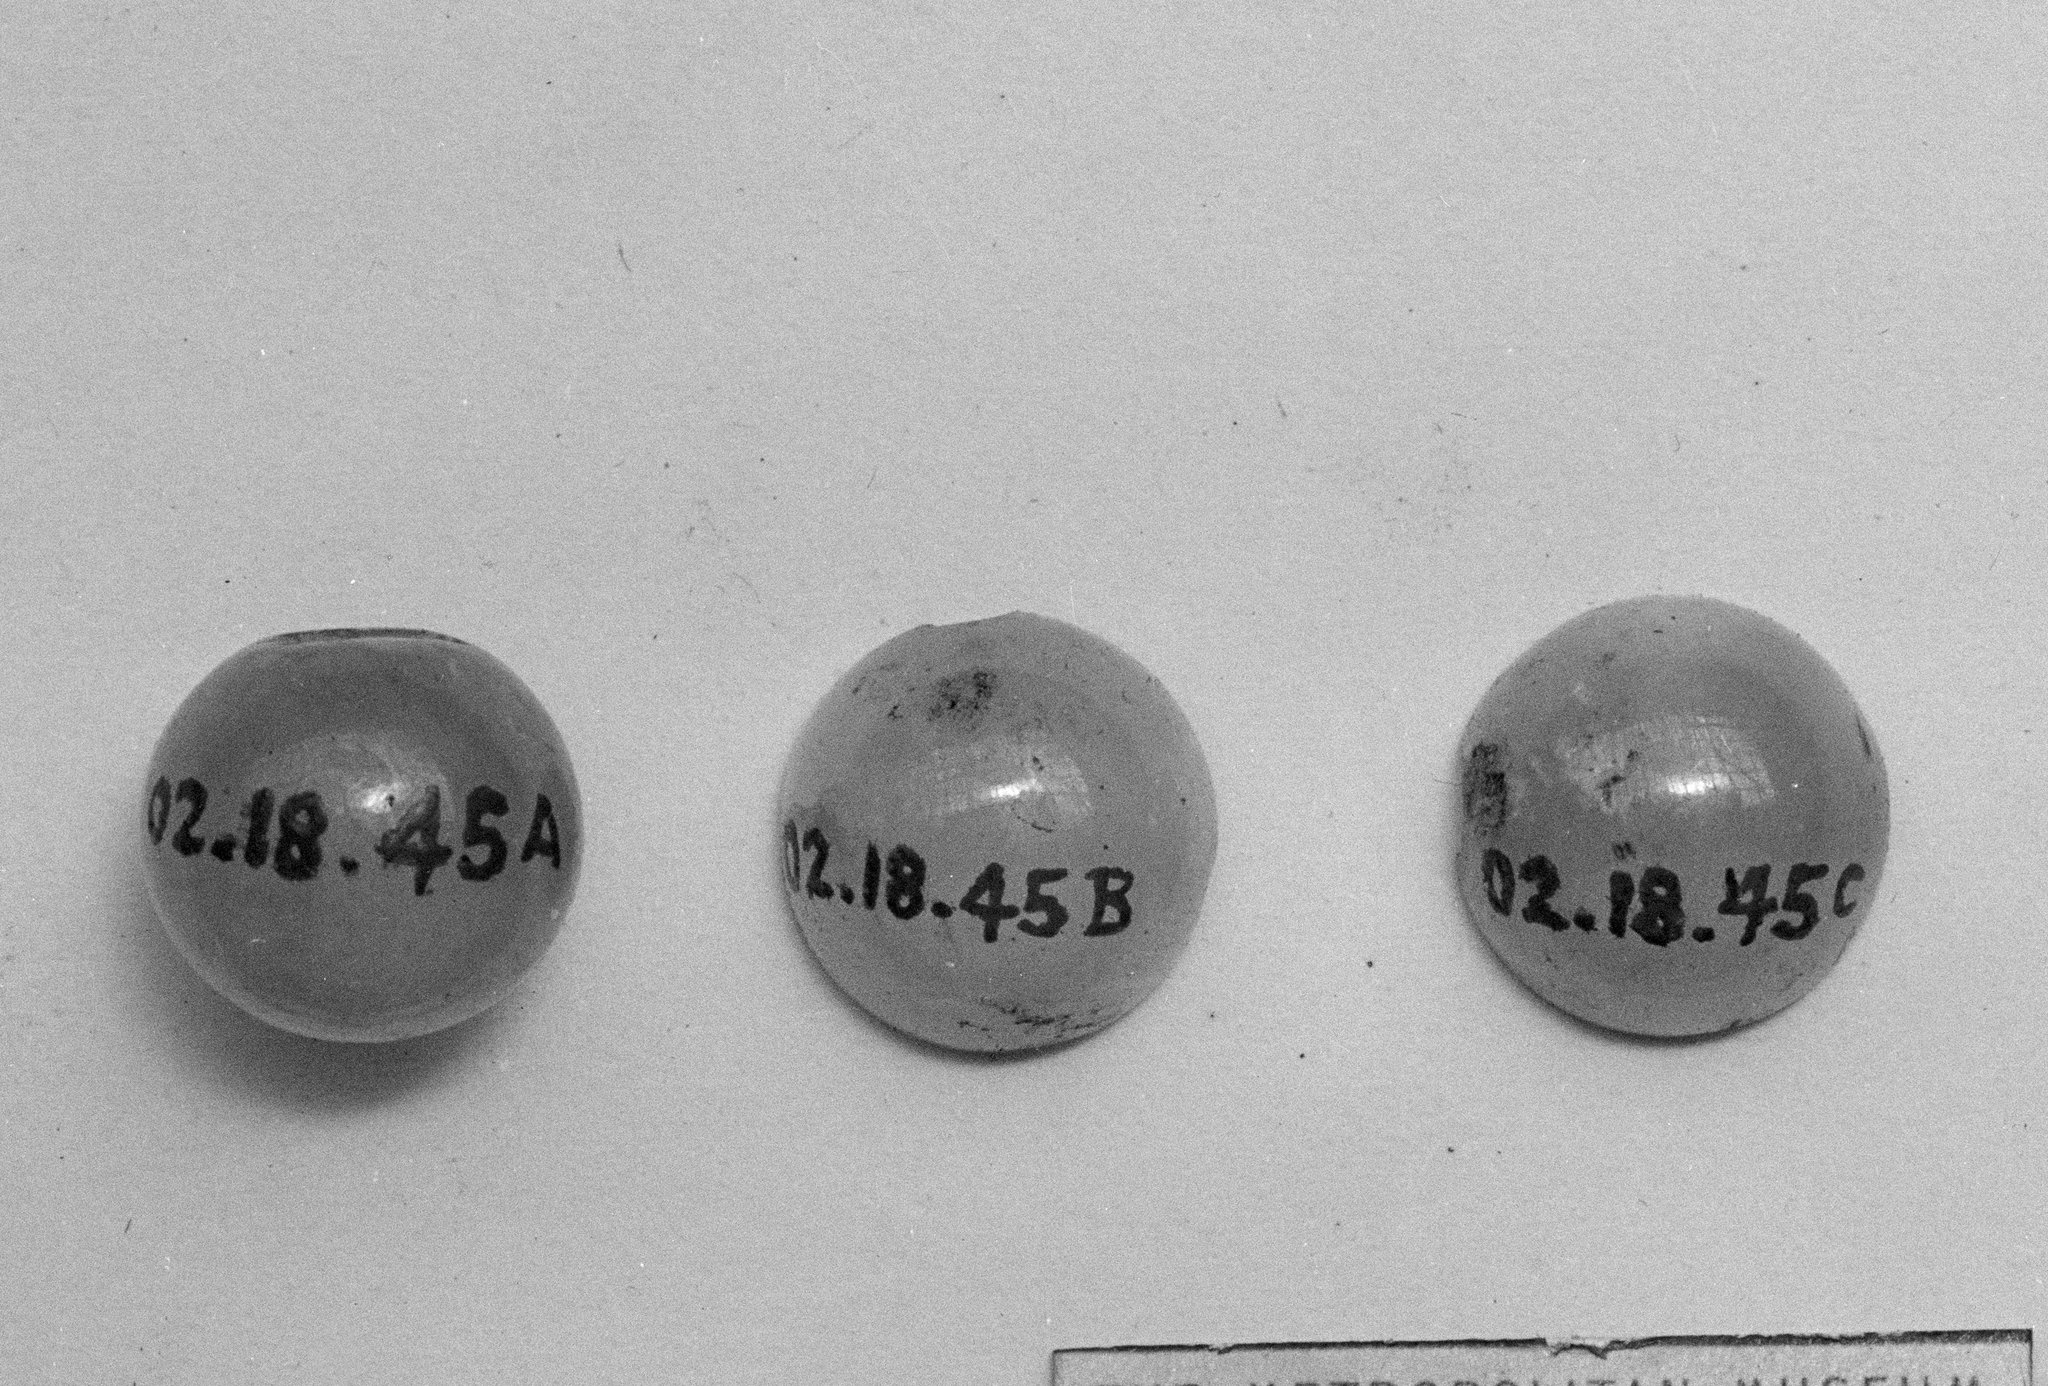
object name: two bead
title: Two Beads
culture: chinese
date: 1902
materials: jade